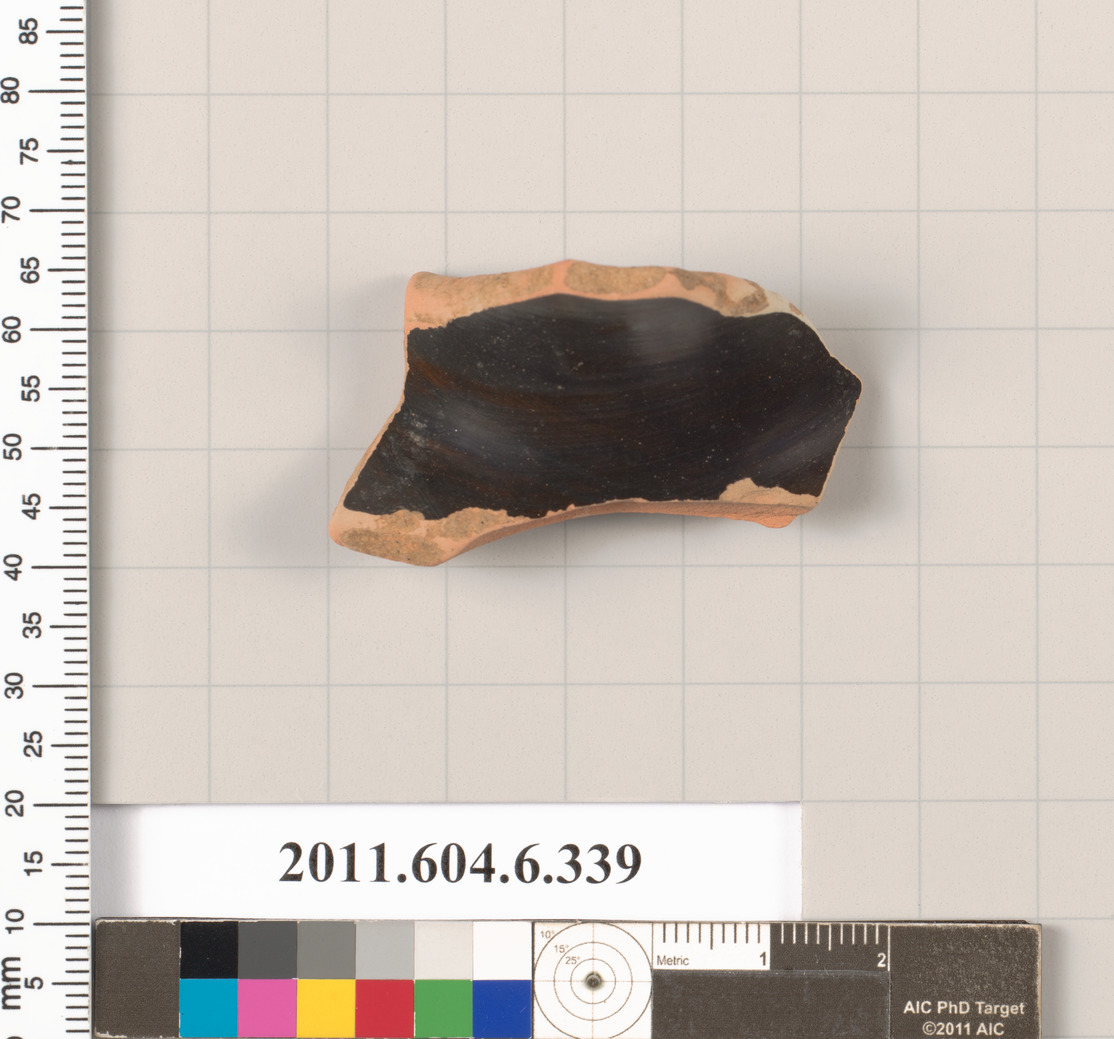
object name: oinochoe fragment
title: Terracotta fragment of an oinochoe (jug)?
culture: greek, attic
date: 600-401 BCE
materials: terracotta